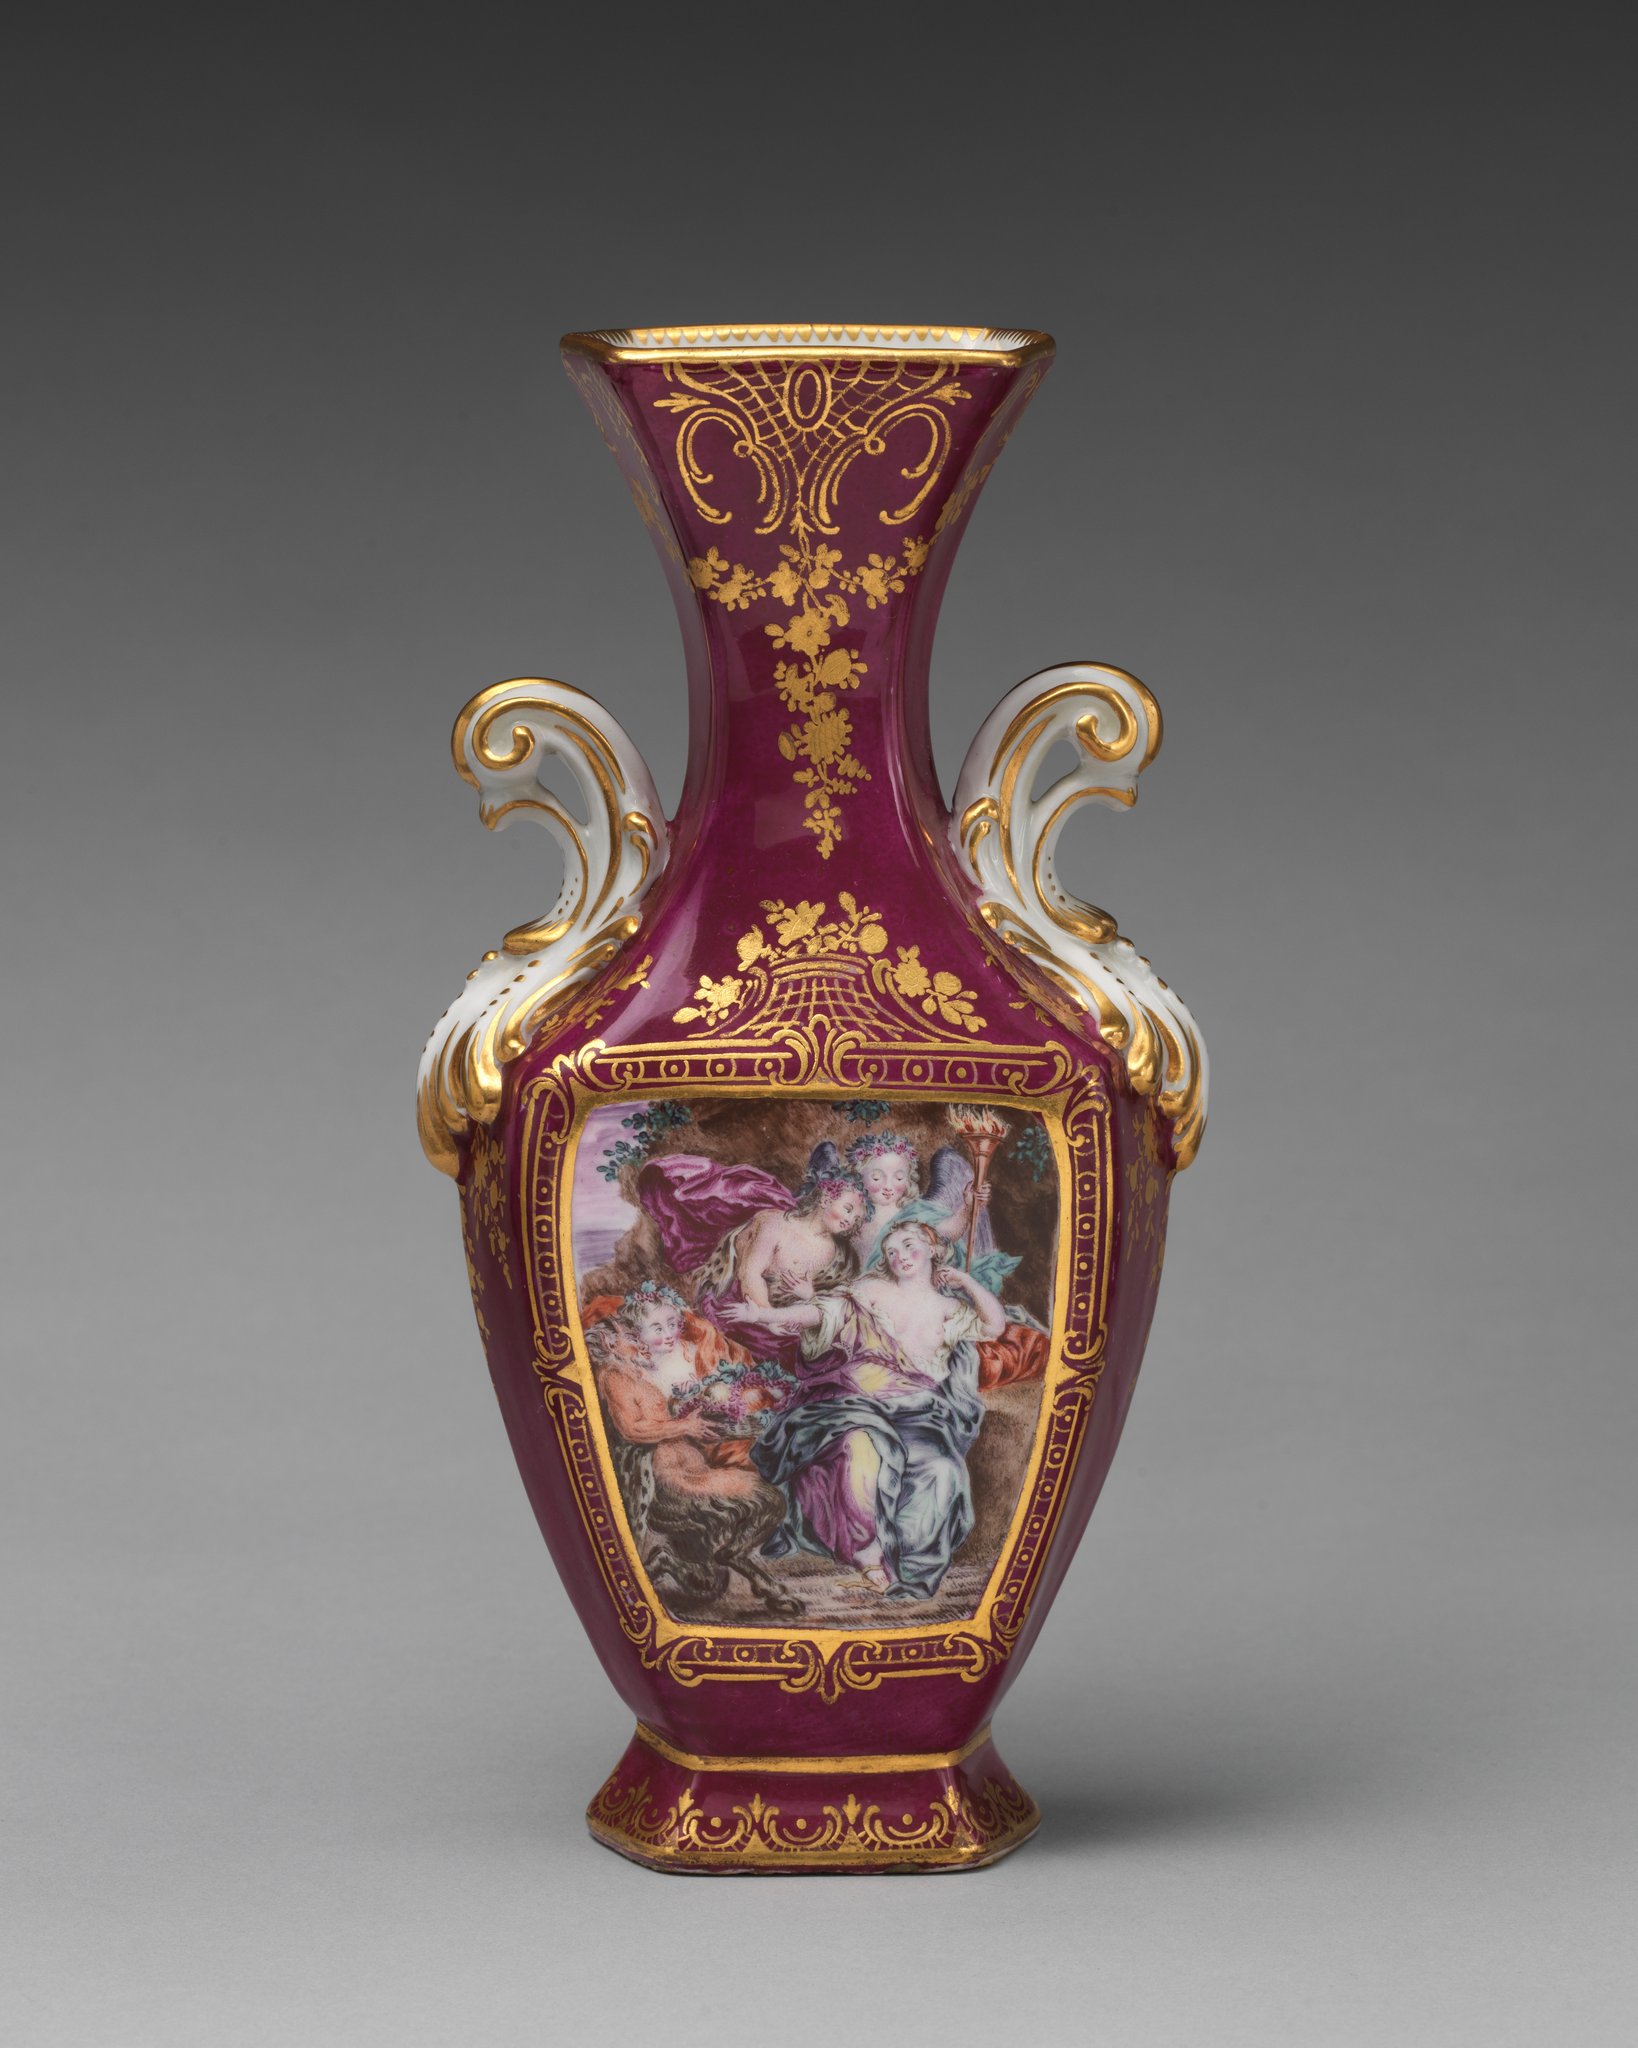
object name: vase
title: Vase (one of a pair)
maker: chelsea porcelain manufactory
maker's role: factory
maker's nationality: british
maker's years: 1744-1784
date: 1761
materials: soft paste porcelain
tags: birds,men,women,flowers